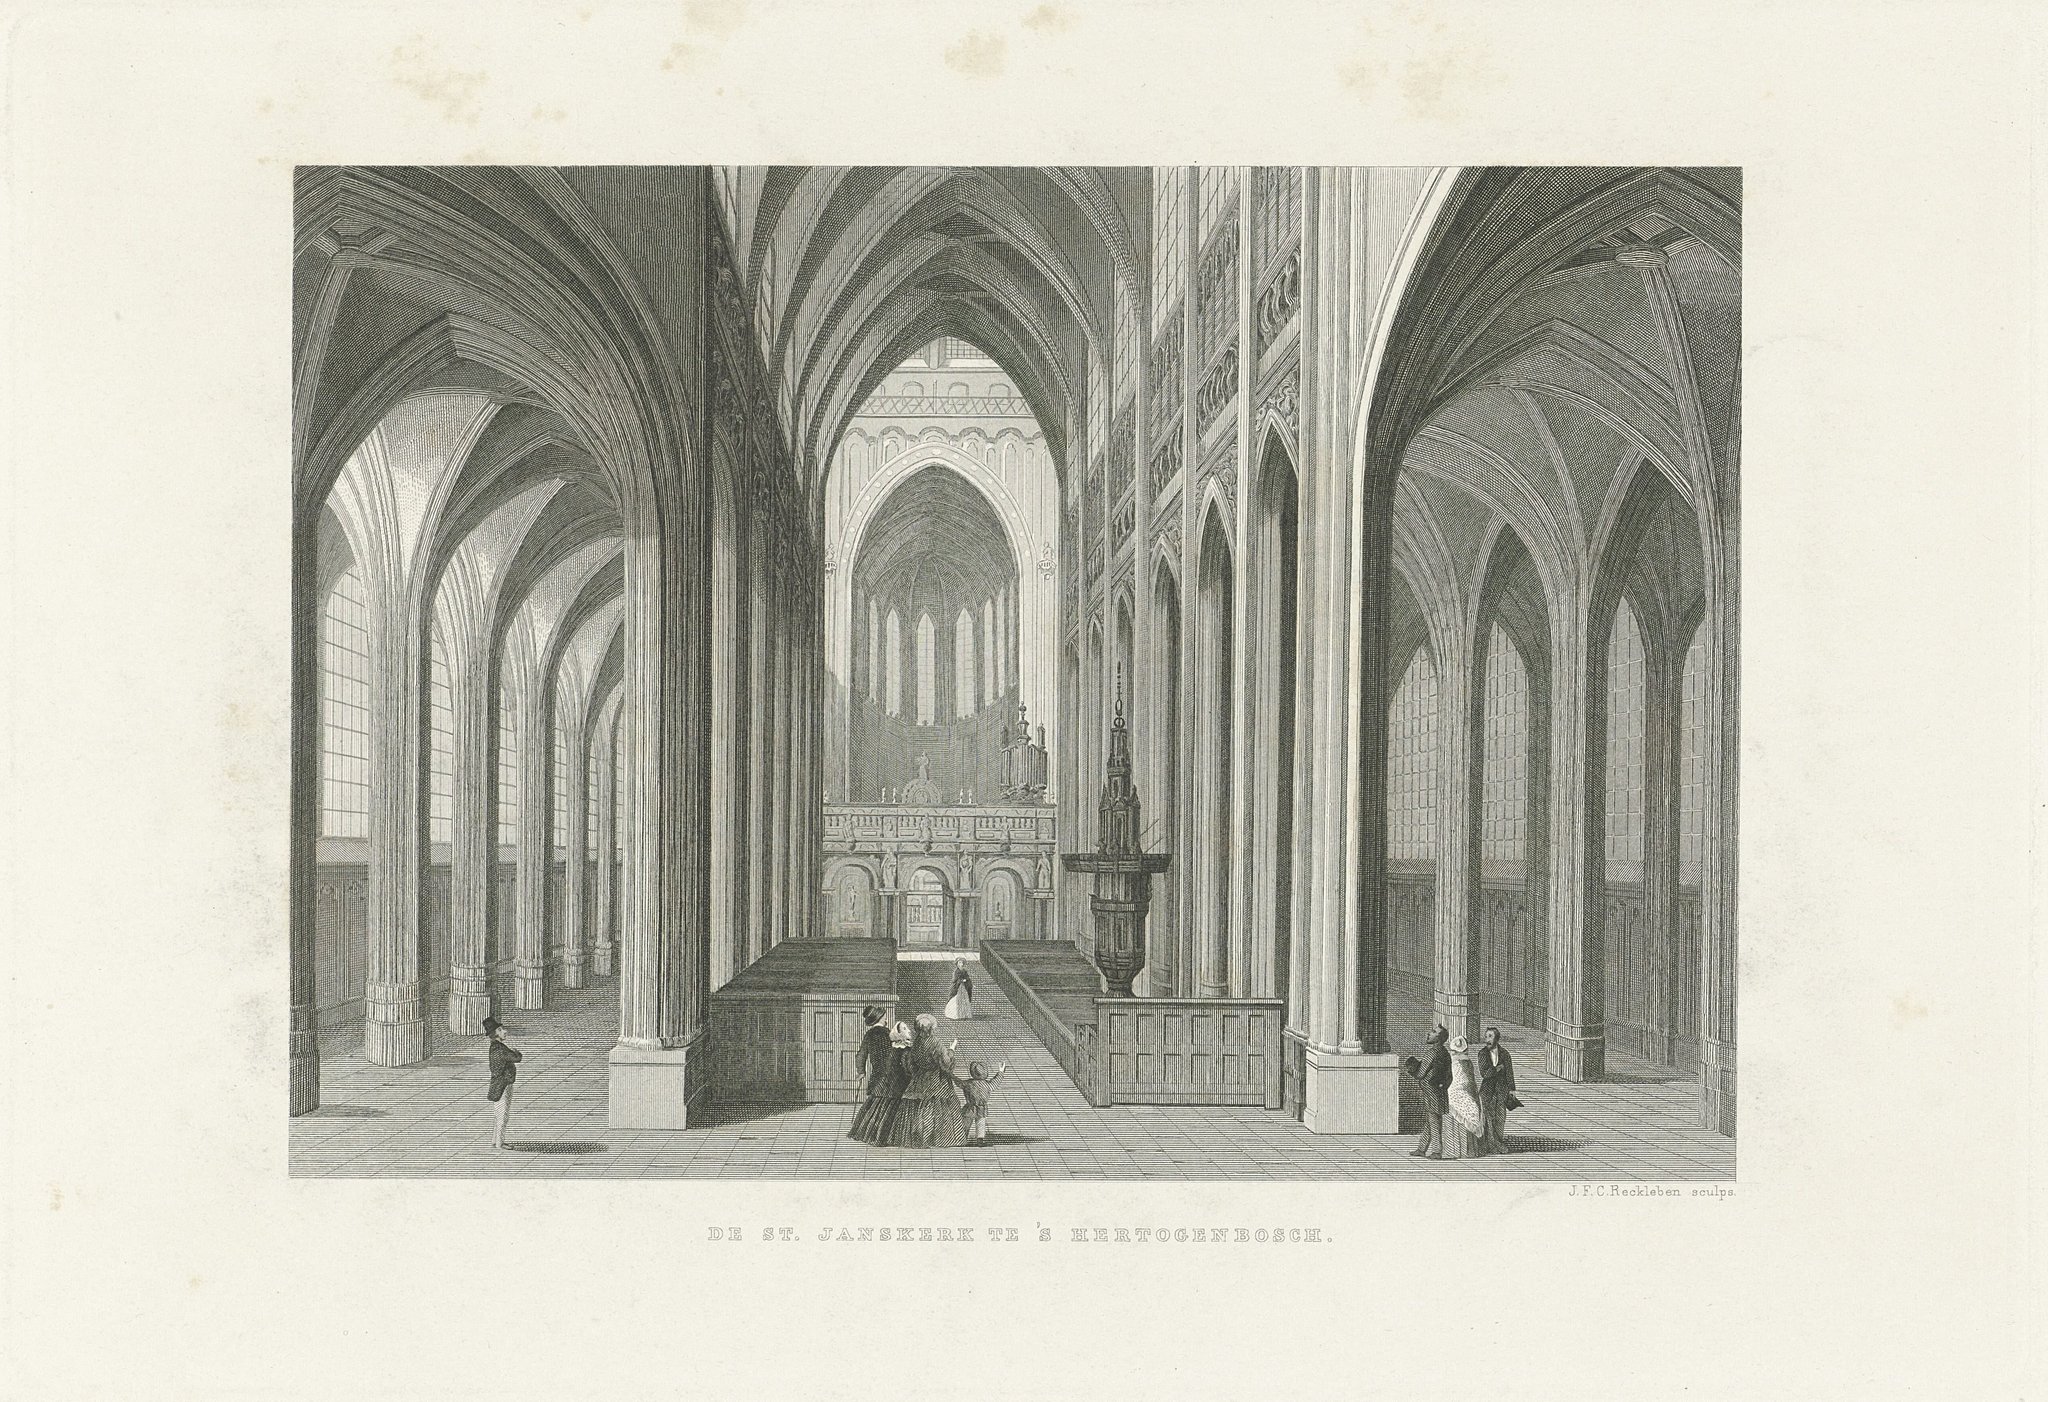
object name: book illustration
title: De St. Janskerk te 's Hertogenbosch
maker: jan frederik christiaan reckleben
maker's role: print maker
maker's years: 1819-1879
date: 1859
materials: paper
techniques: engraving, etching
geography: amsterdam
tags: sint-janskathedraal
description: Gebruikt als illustratie in: N. Beets, Geschiedenis der Christelijke kerk in tafereelen; 5 dln, dl. 5: Zesde tijdvak: [Van den Munsterschen vrede tot op onze dagen], Portielje, Amsterdam 1859, p. 300.